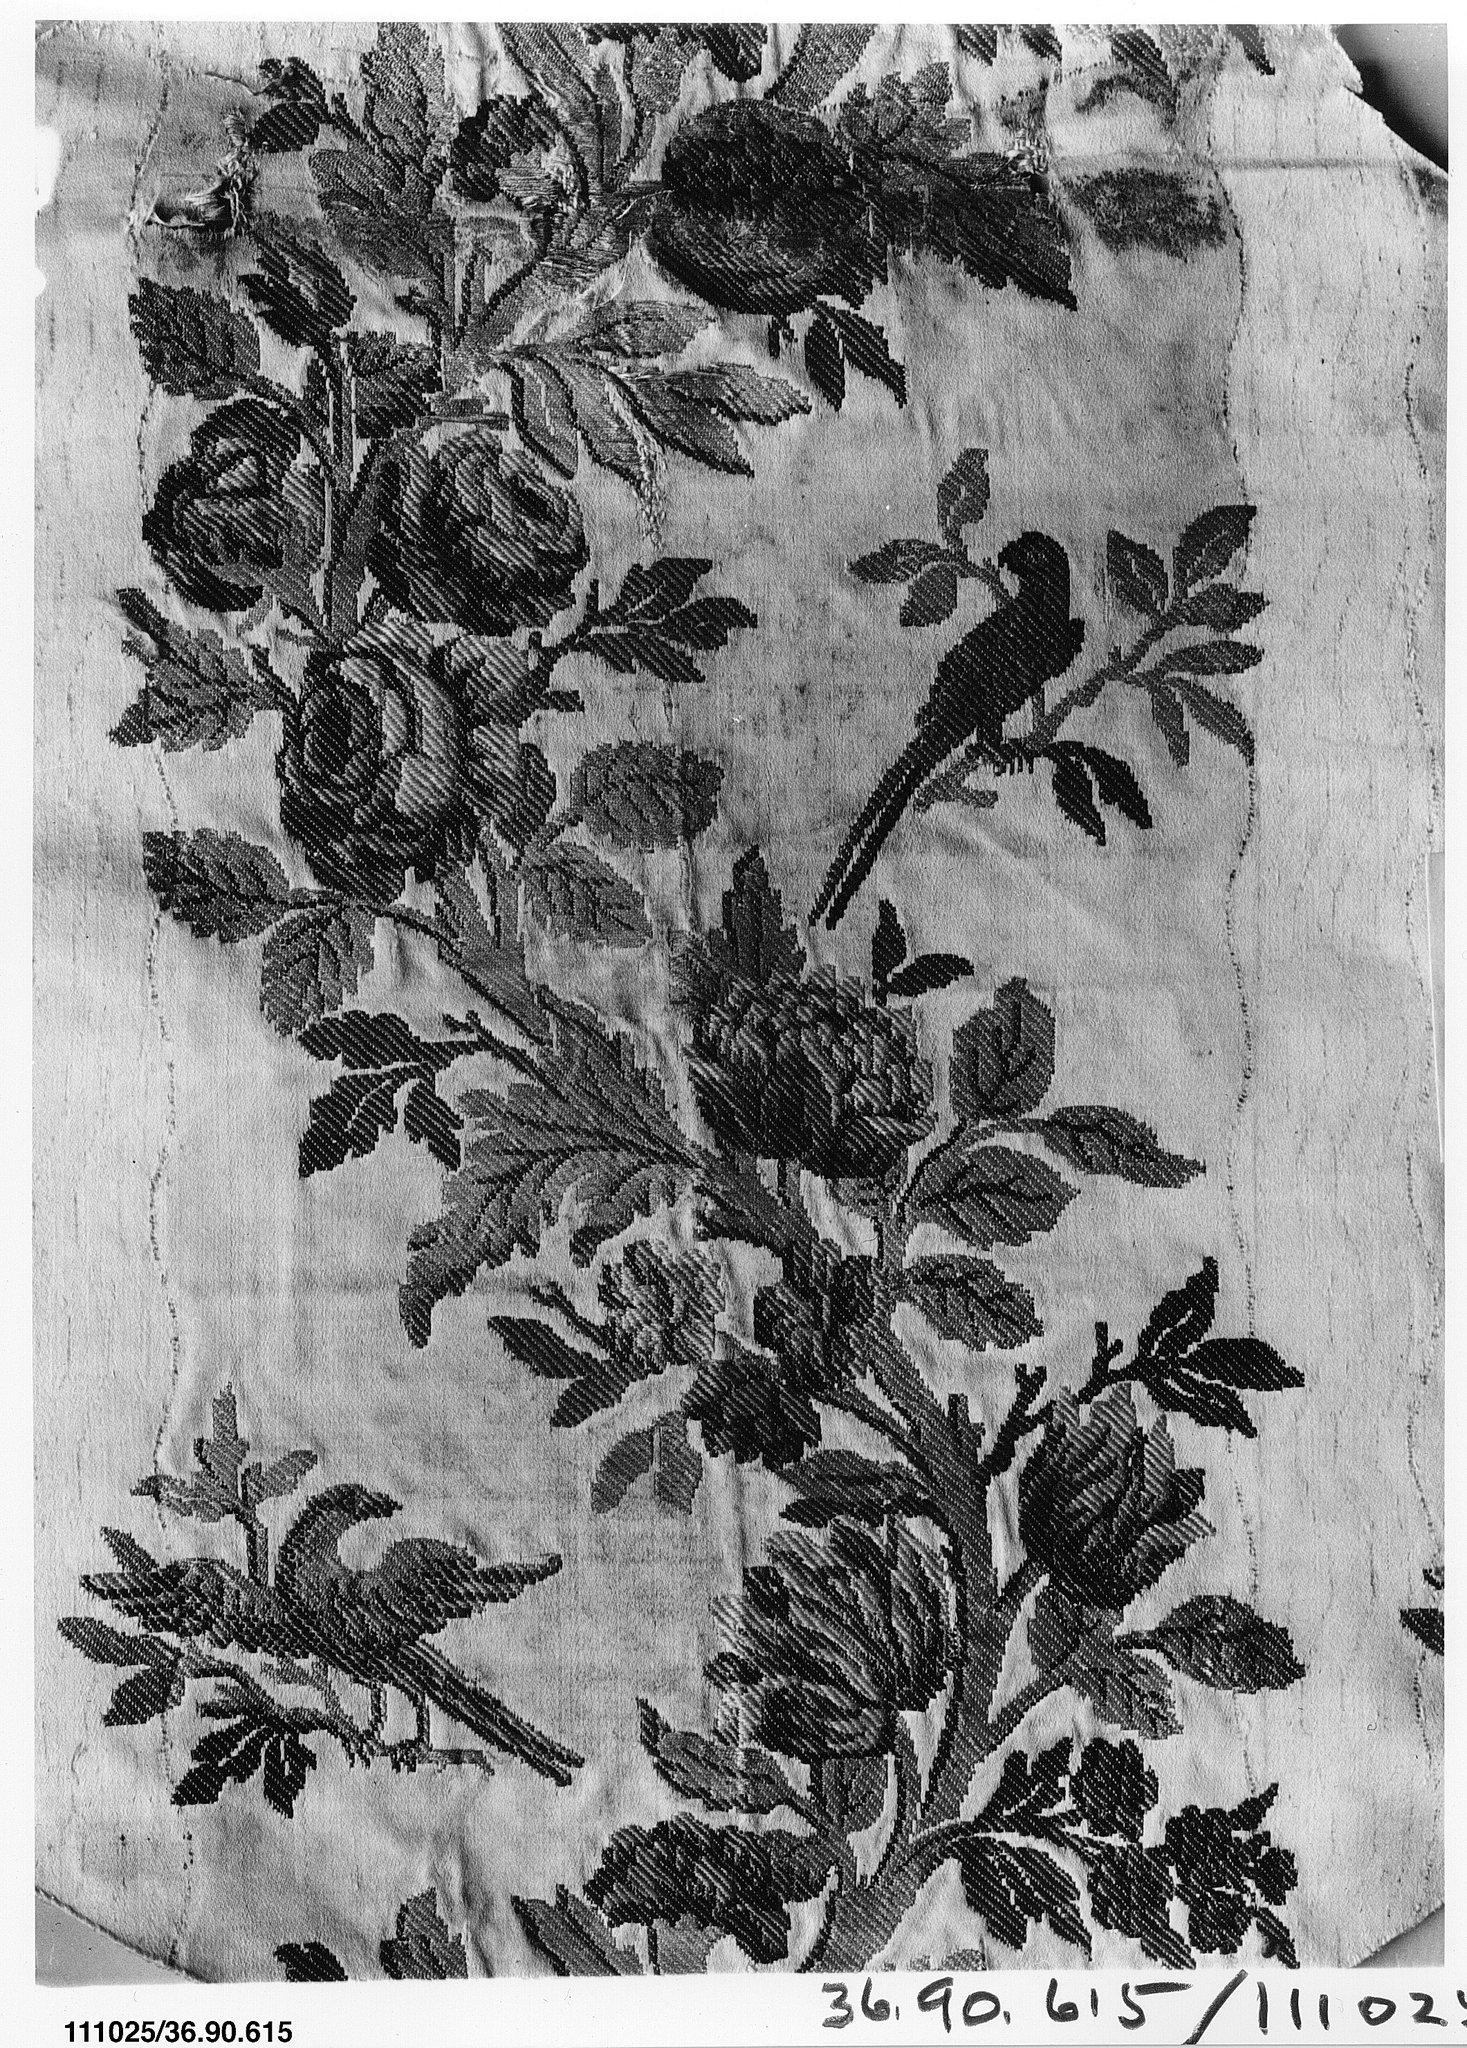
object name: piece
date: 1734-1766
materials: metal thread, silk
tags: birds,roses,leaves